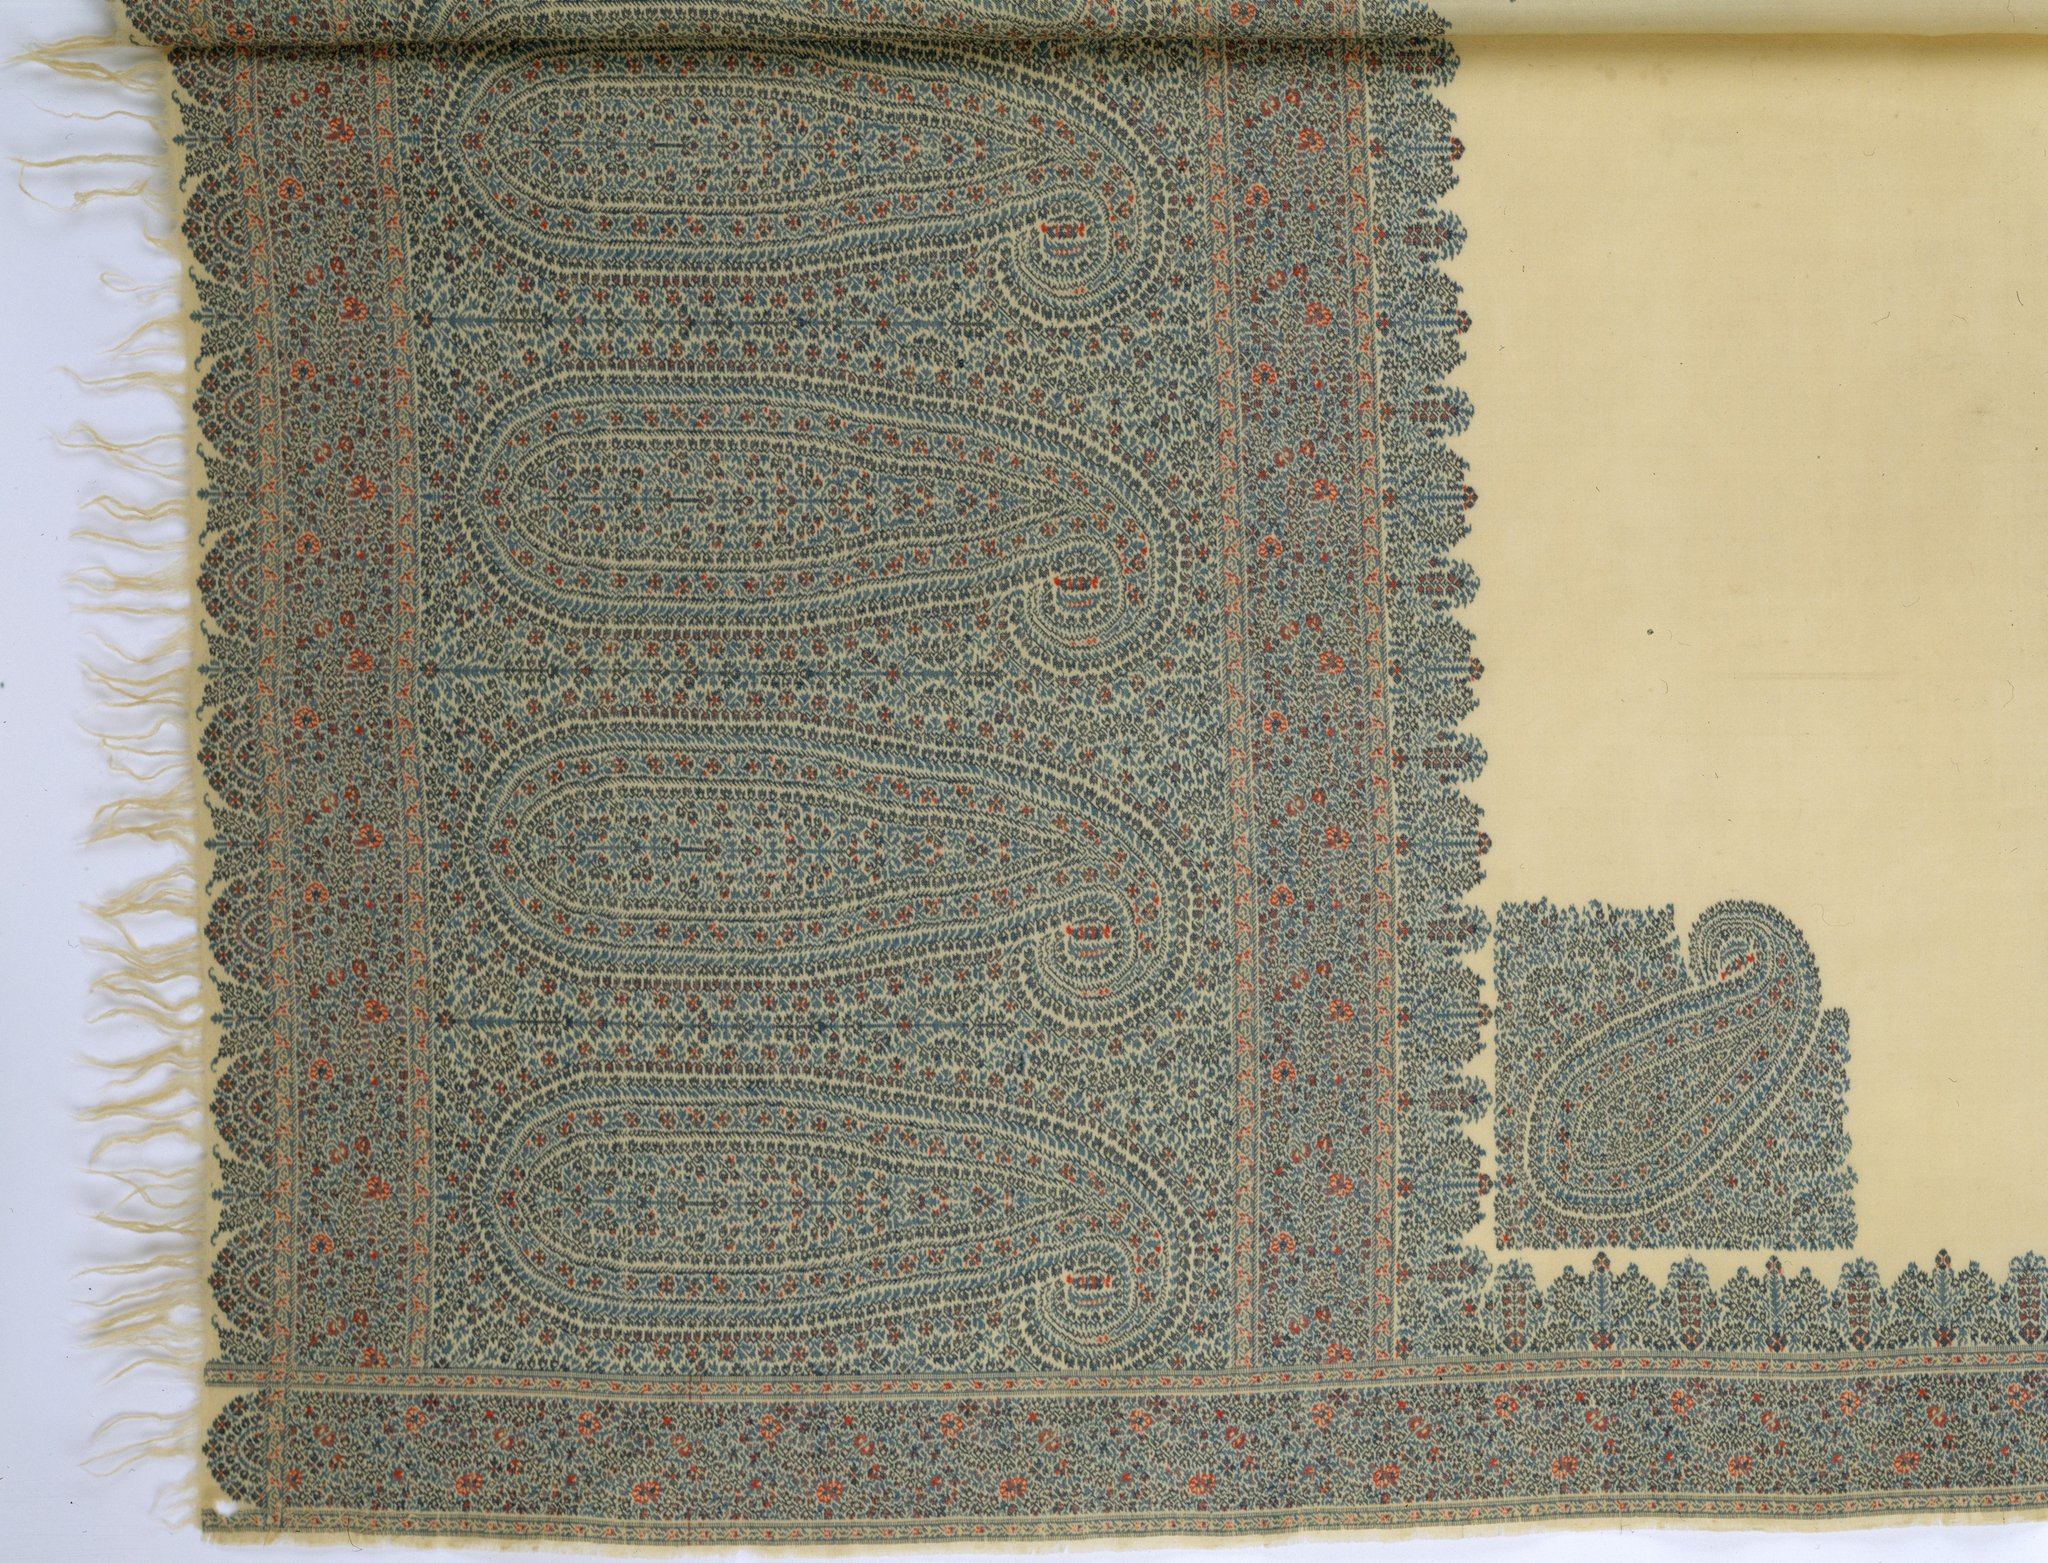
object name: shawl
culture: european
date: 1825-1830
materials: wool